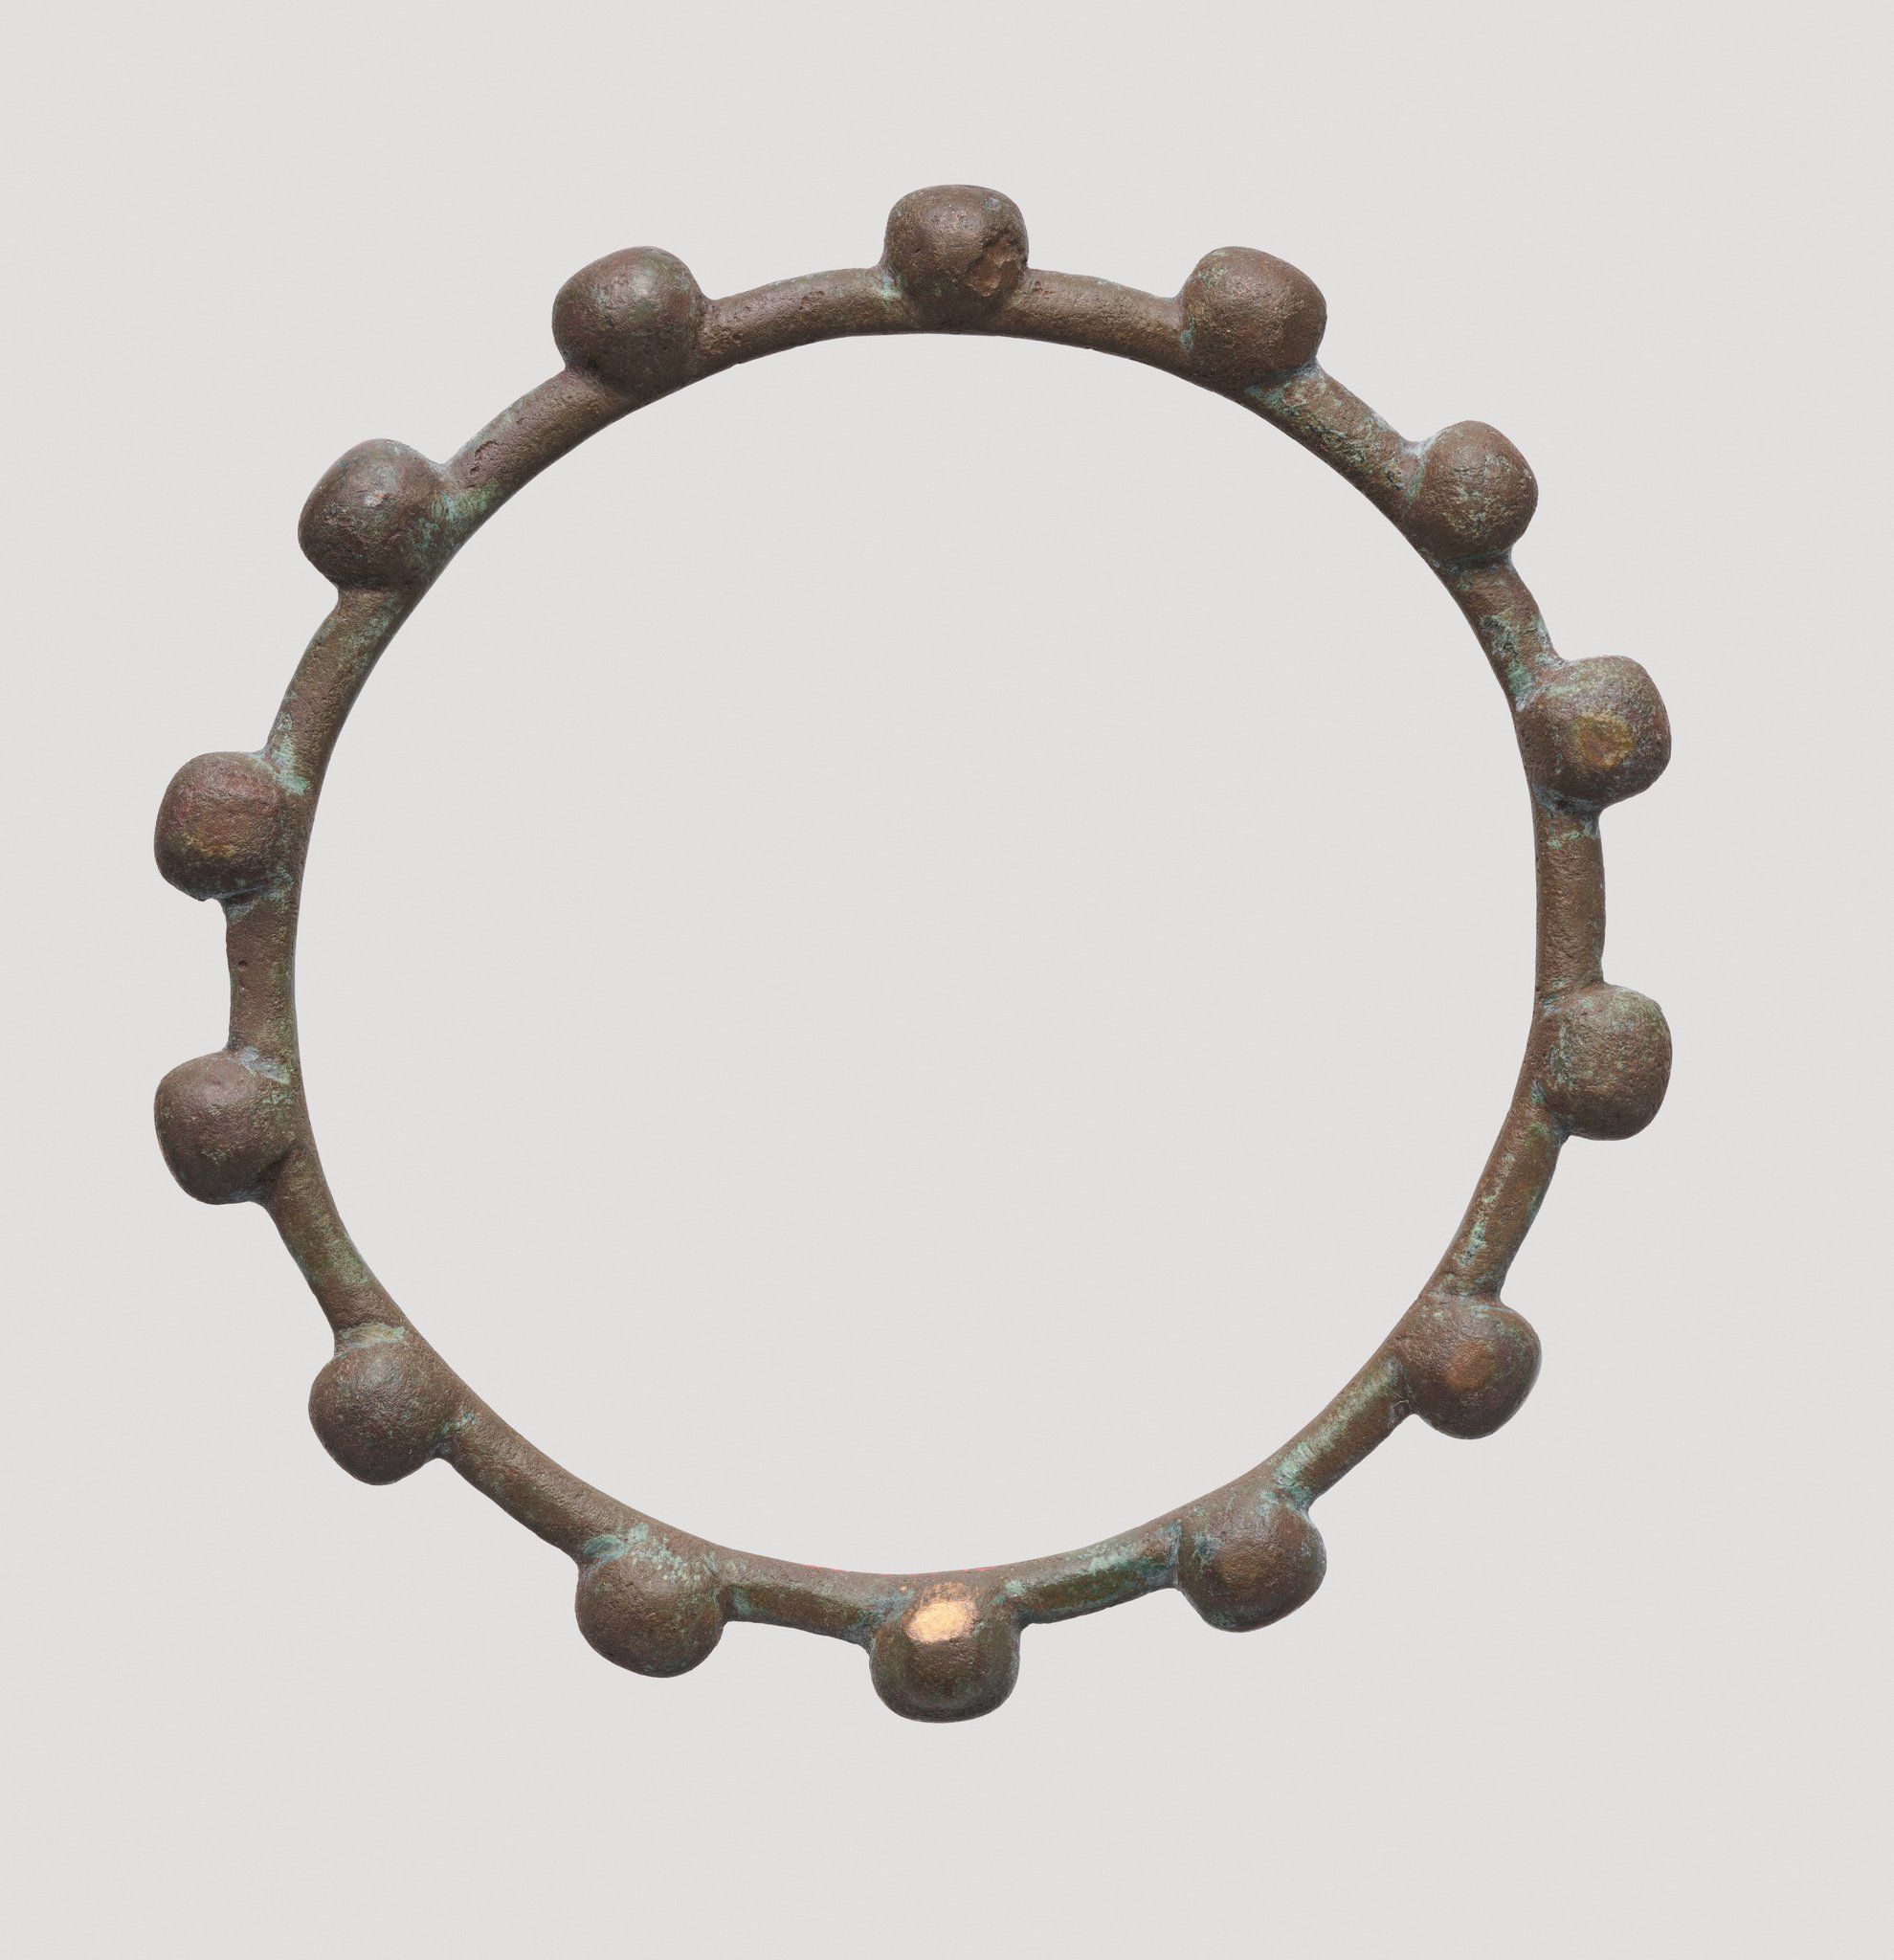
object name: bracelet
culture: iranian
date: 900-801 BCE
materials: bronze, copper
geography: iran